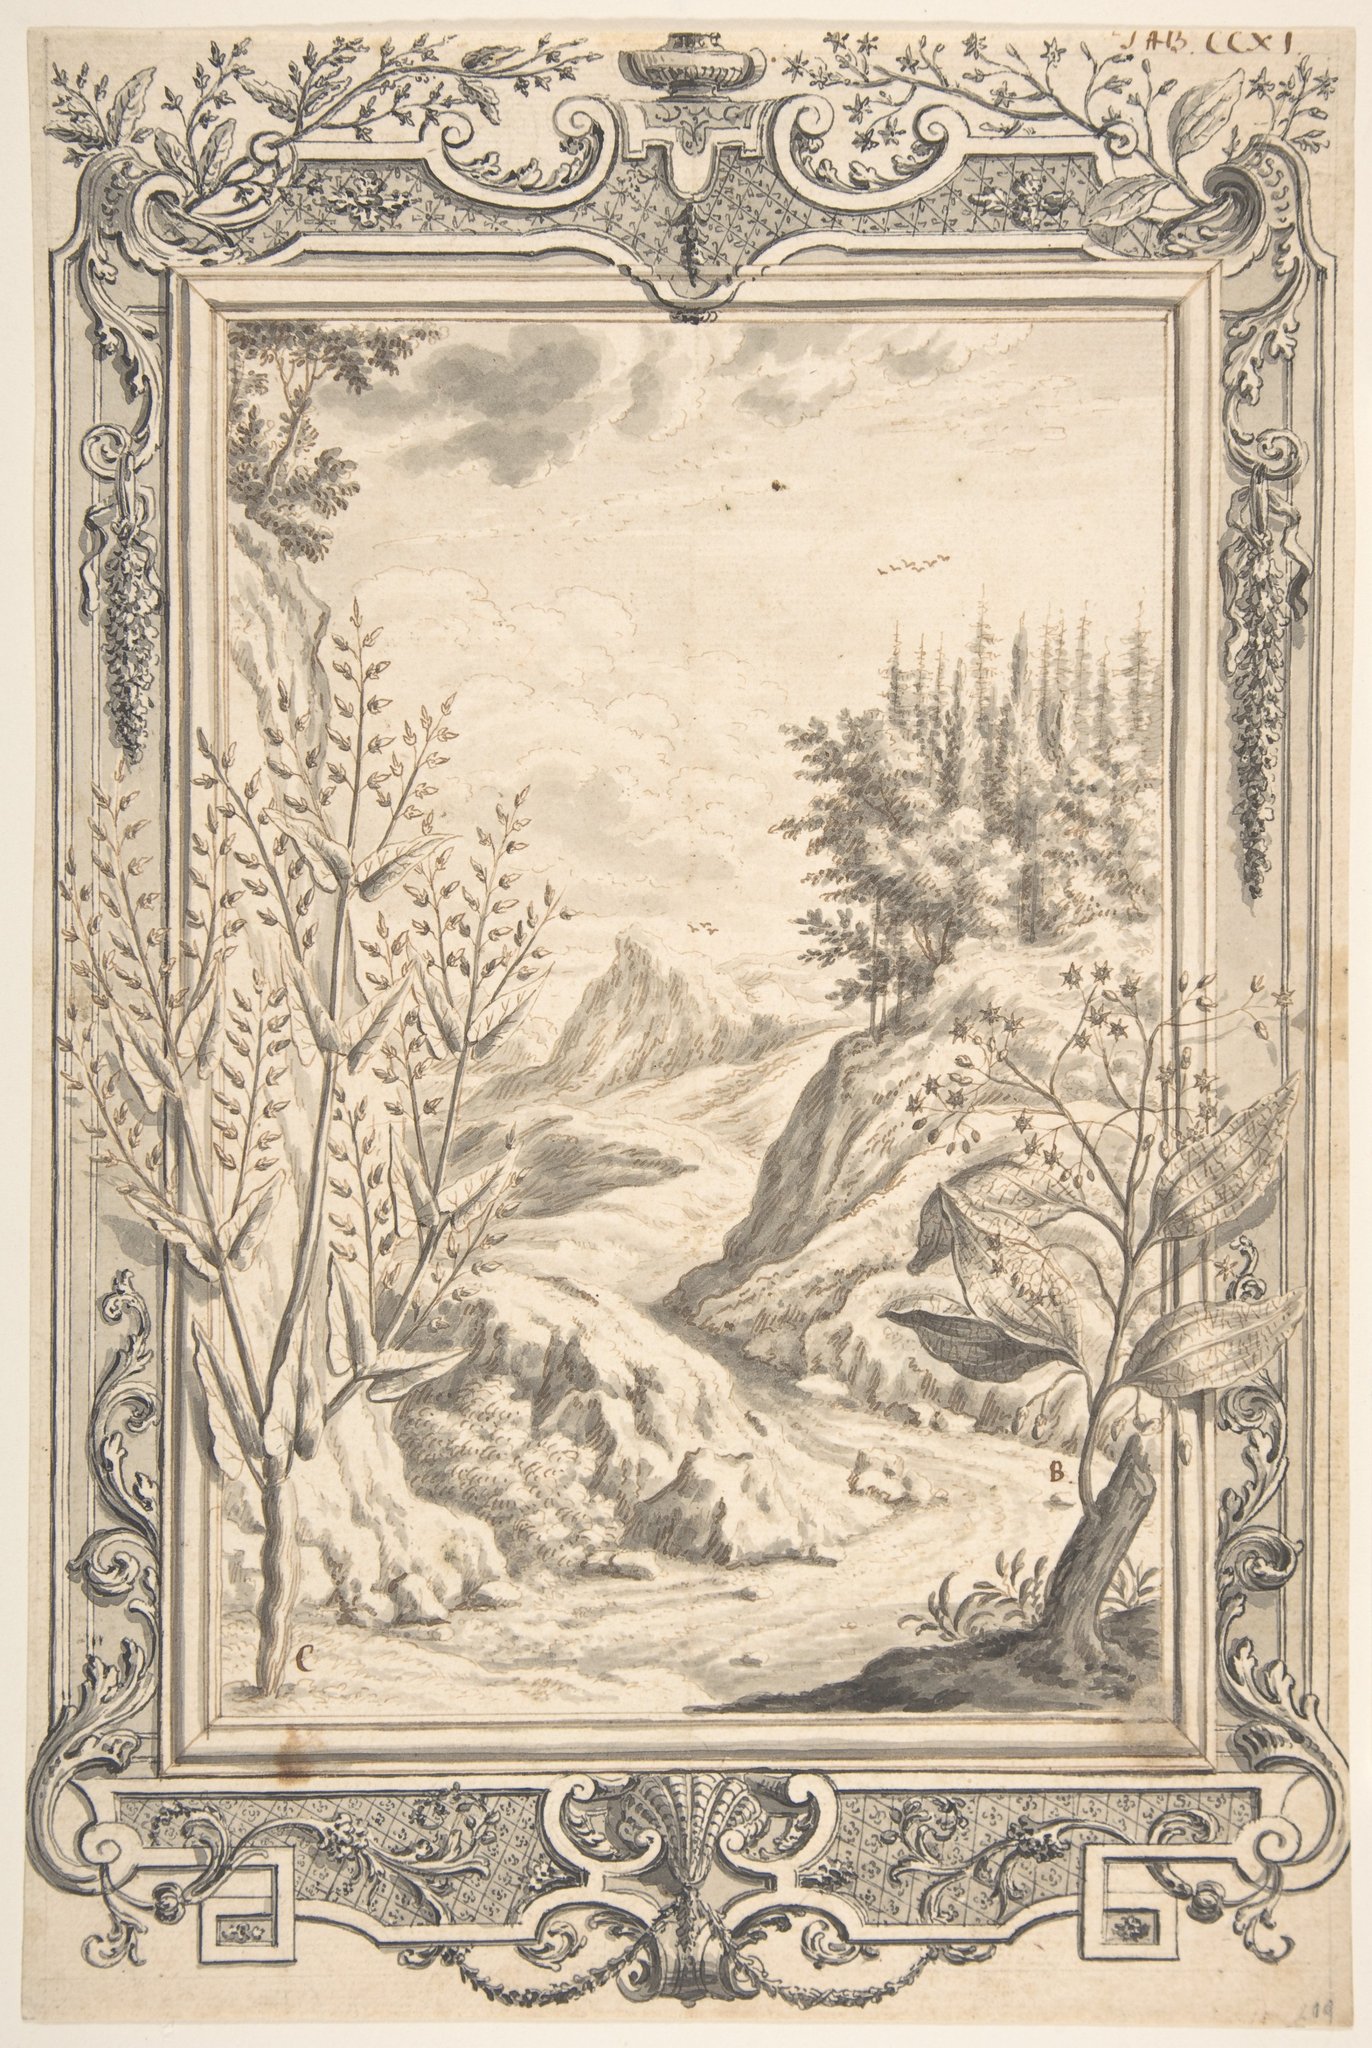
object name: drawing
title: Landscape with Ornamental Frame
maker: johann melchior füssli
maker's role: artist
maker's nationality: swiss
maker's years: 1677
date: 1730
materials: chalk, ink, paper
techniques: brush, pen, drawing, wash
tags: landscapes